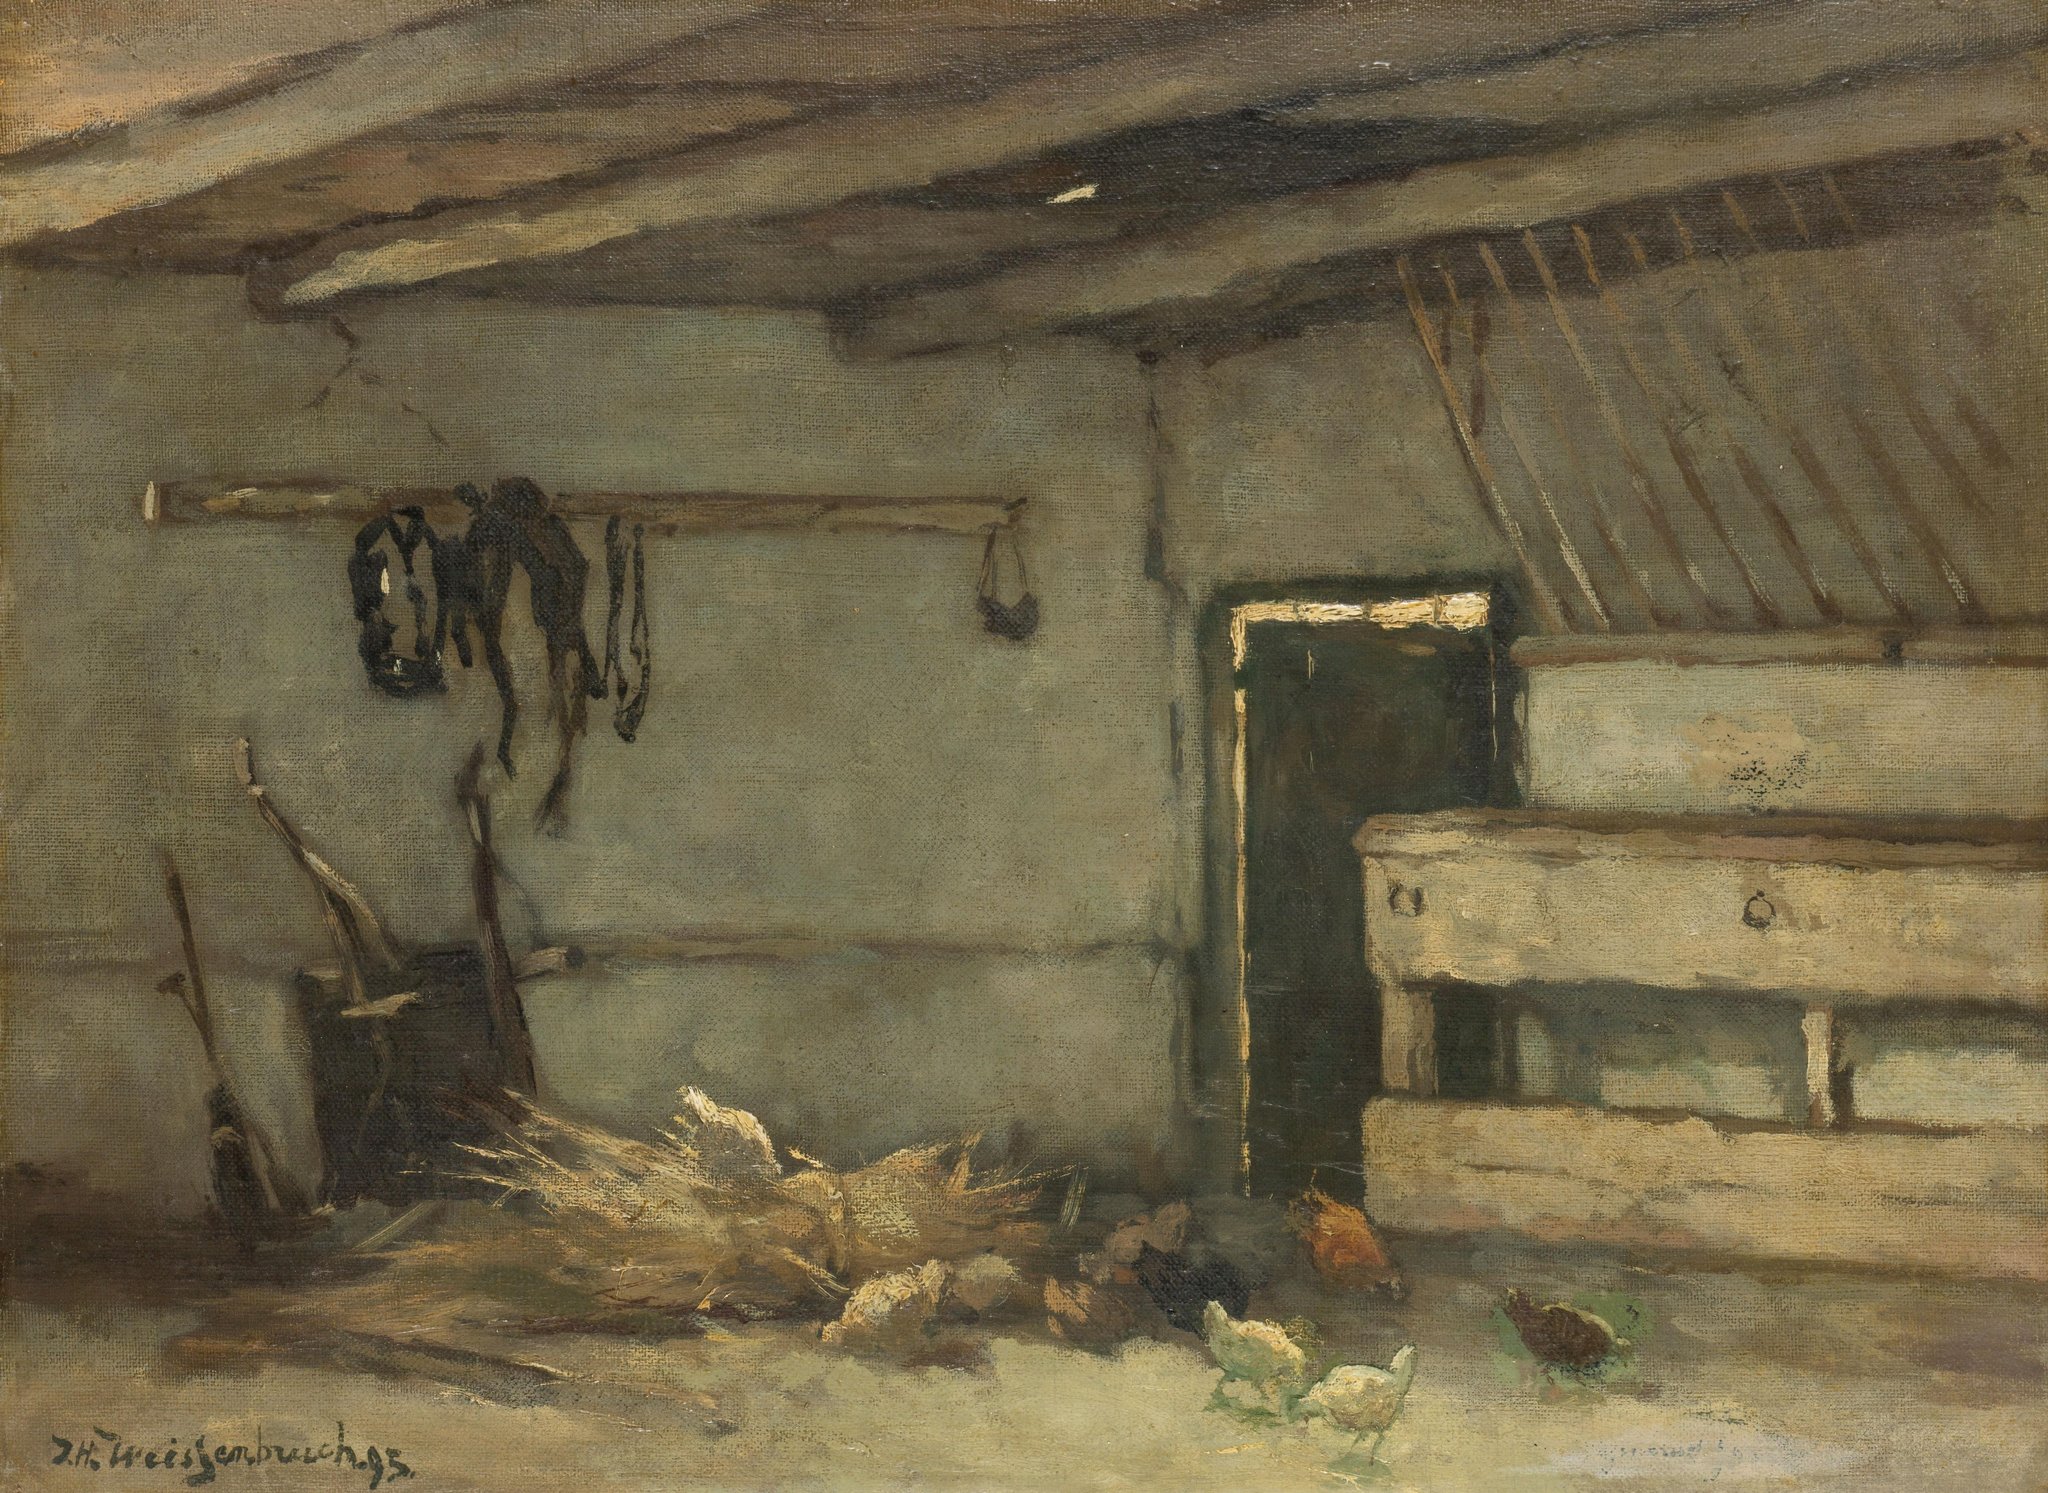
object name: painting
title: Interior of a Stable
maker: johan hendrik weissenbruch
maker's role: draughtsman, painter, print maker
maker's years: 1824-1903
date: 1895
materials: canvas, oil, panel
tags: fowl (cock, hen, chicken, etc.), stall, stable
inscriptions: signature and date: ‘J.H. Weissenbruch '95’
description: Interieur van een stal, tussen het stro op de grond scharrelen kippen, tegen de wand staat een kruiwagen.